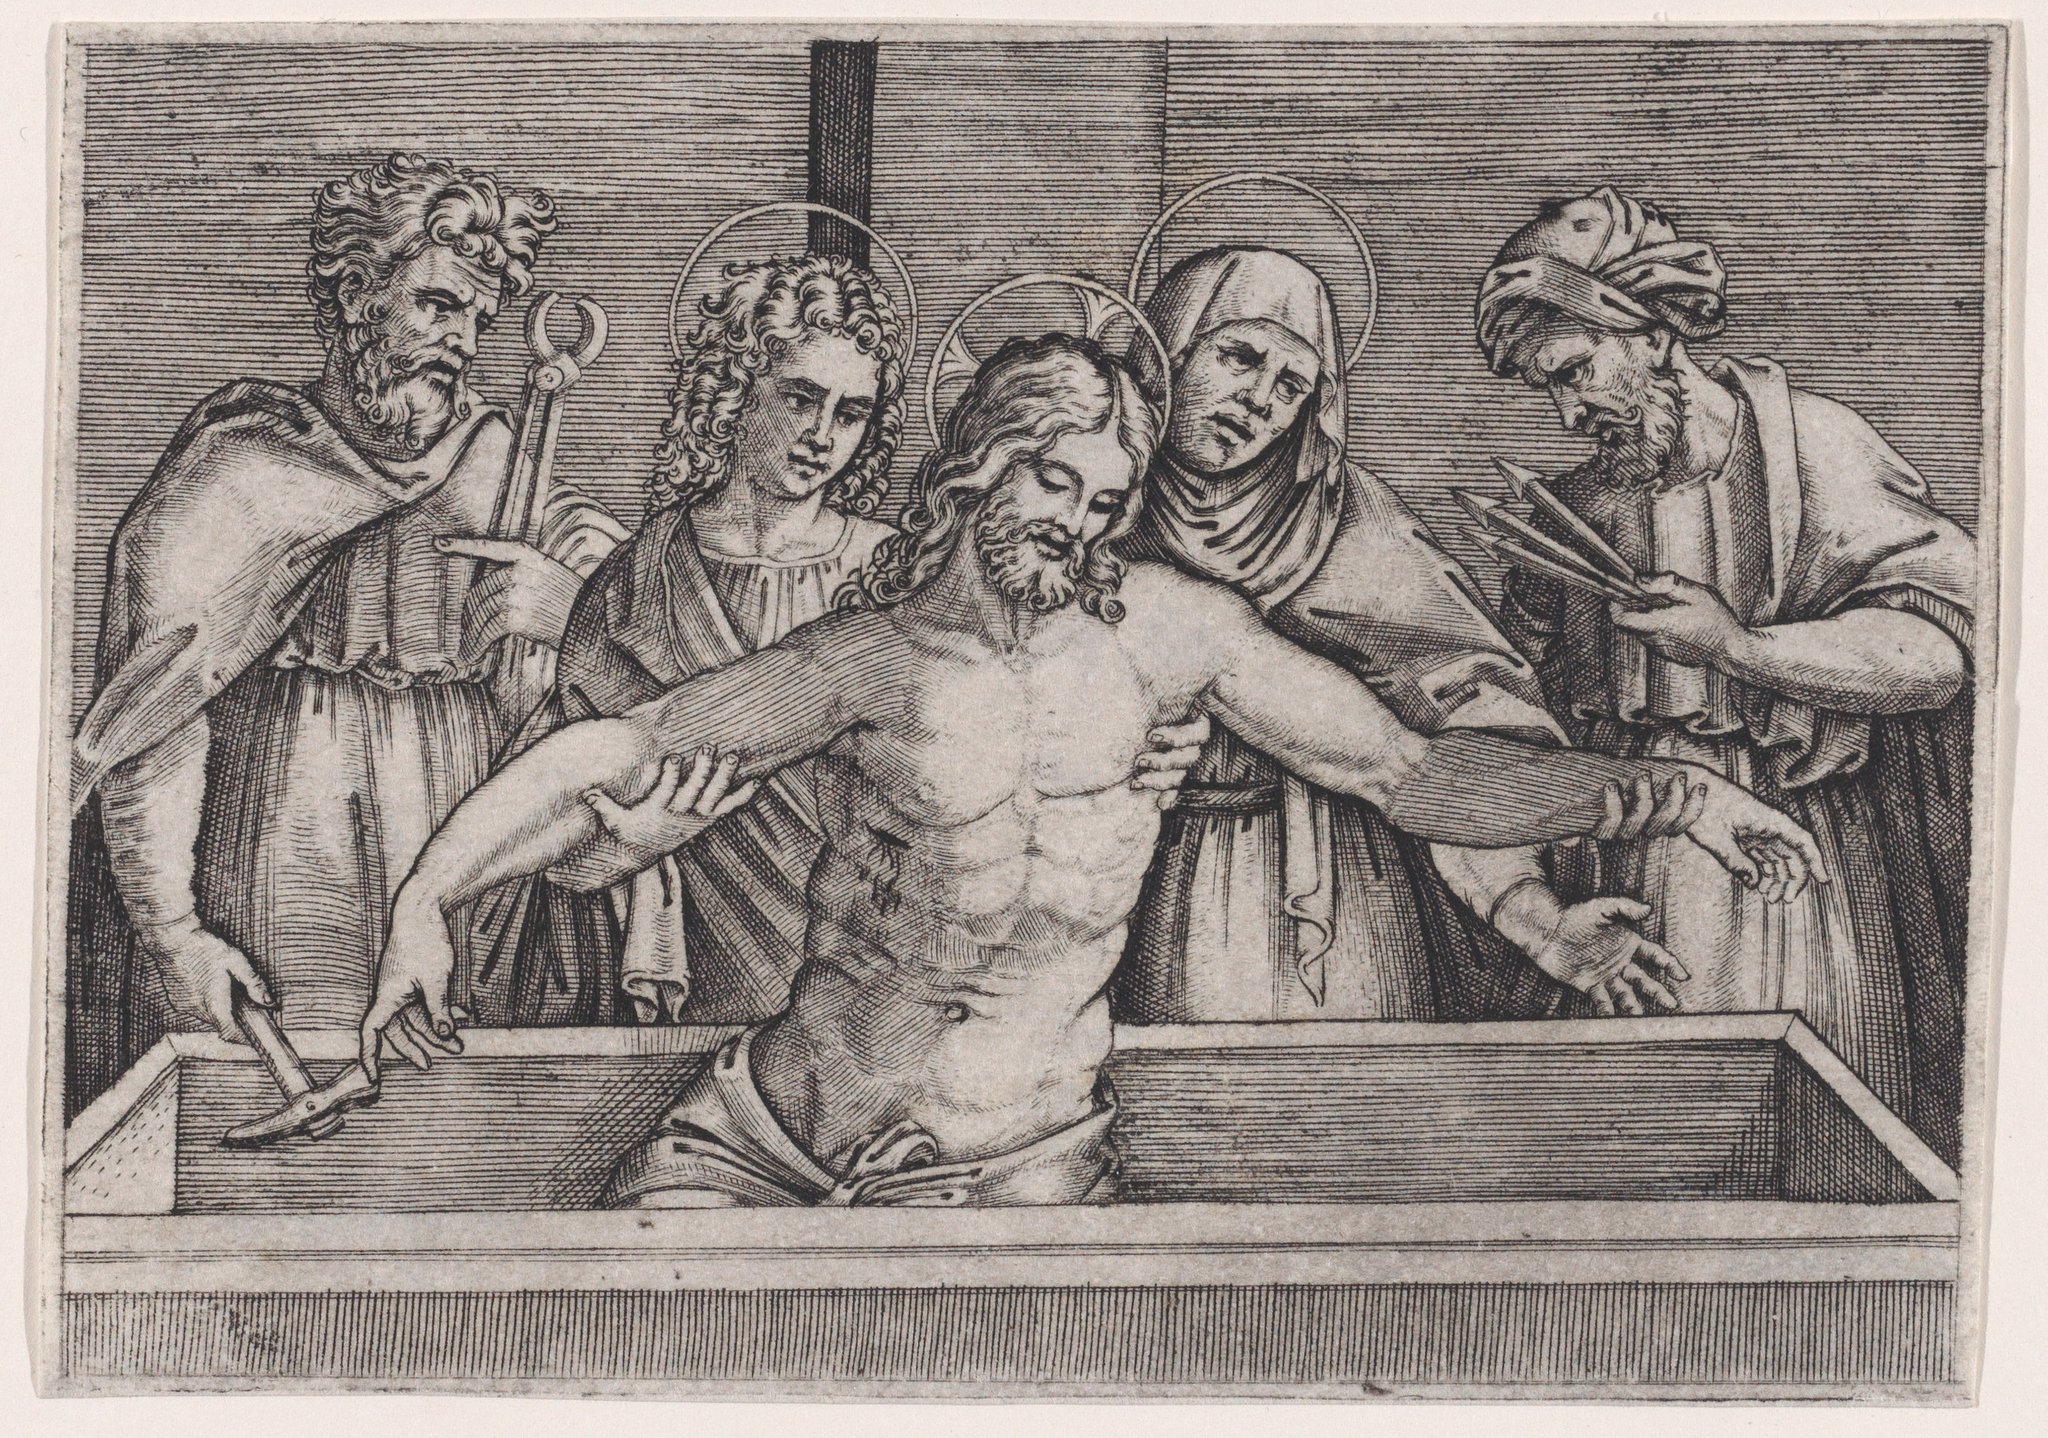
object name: print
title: The Entombment of Christ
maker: agostino veneziano (agostino dei musi)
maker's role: artist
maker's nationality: italian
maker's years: 1490-1536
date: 1514-1536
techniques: engraving